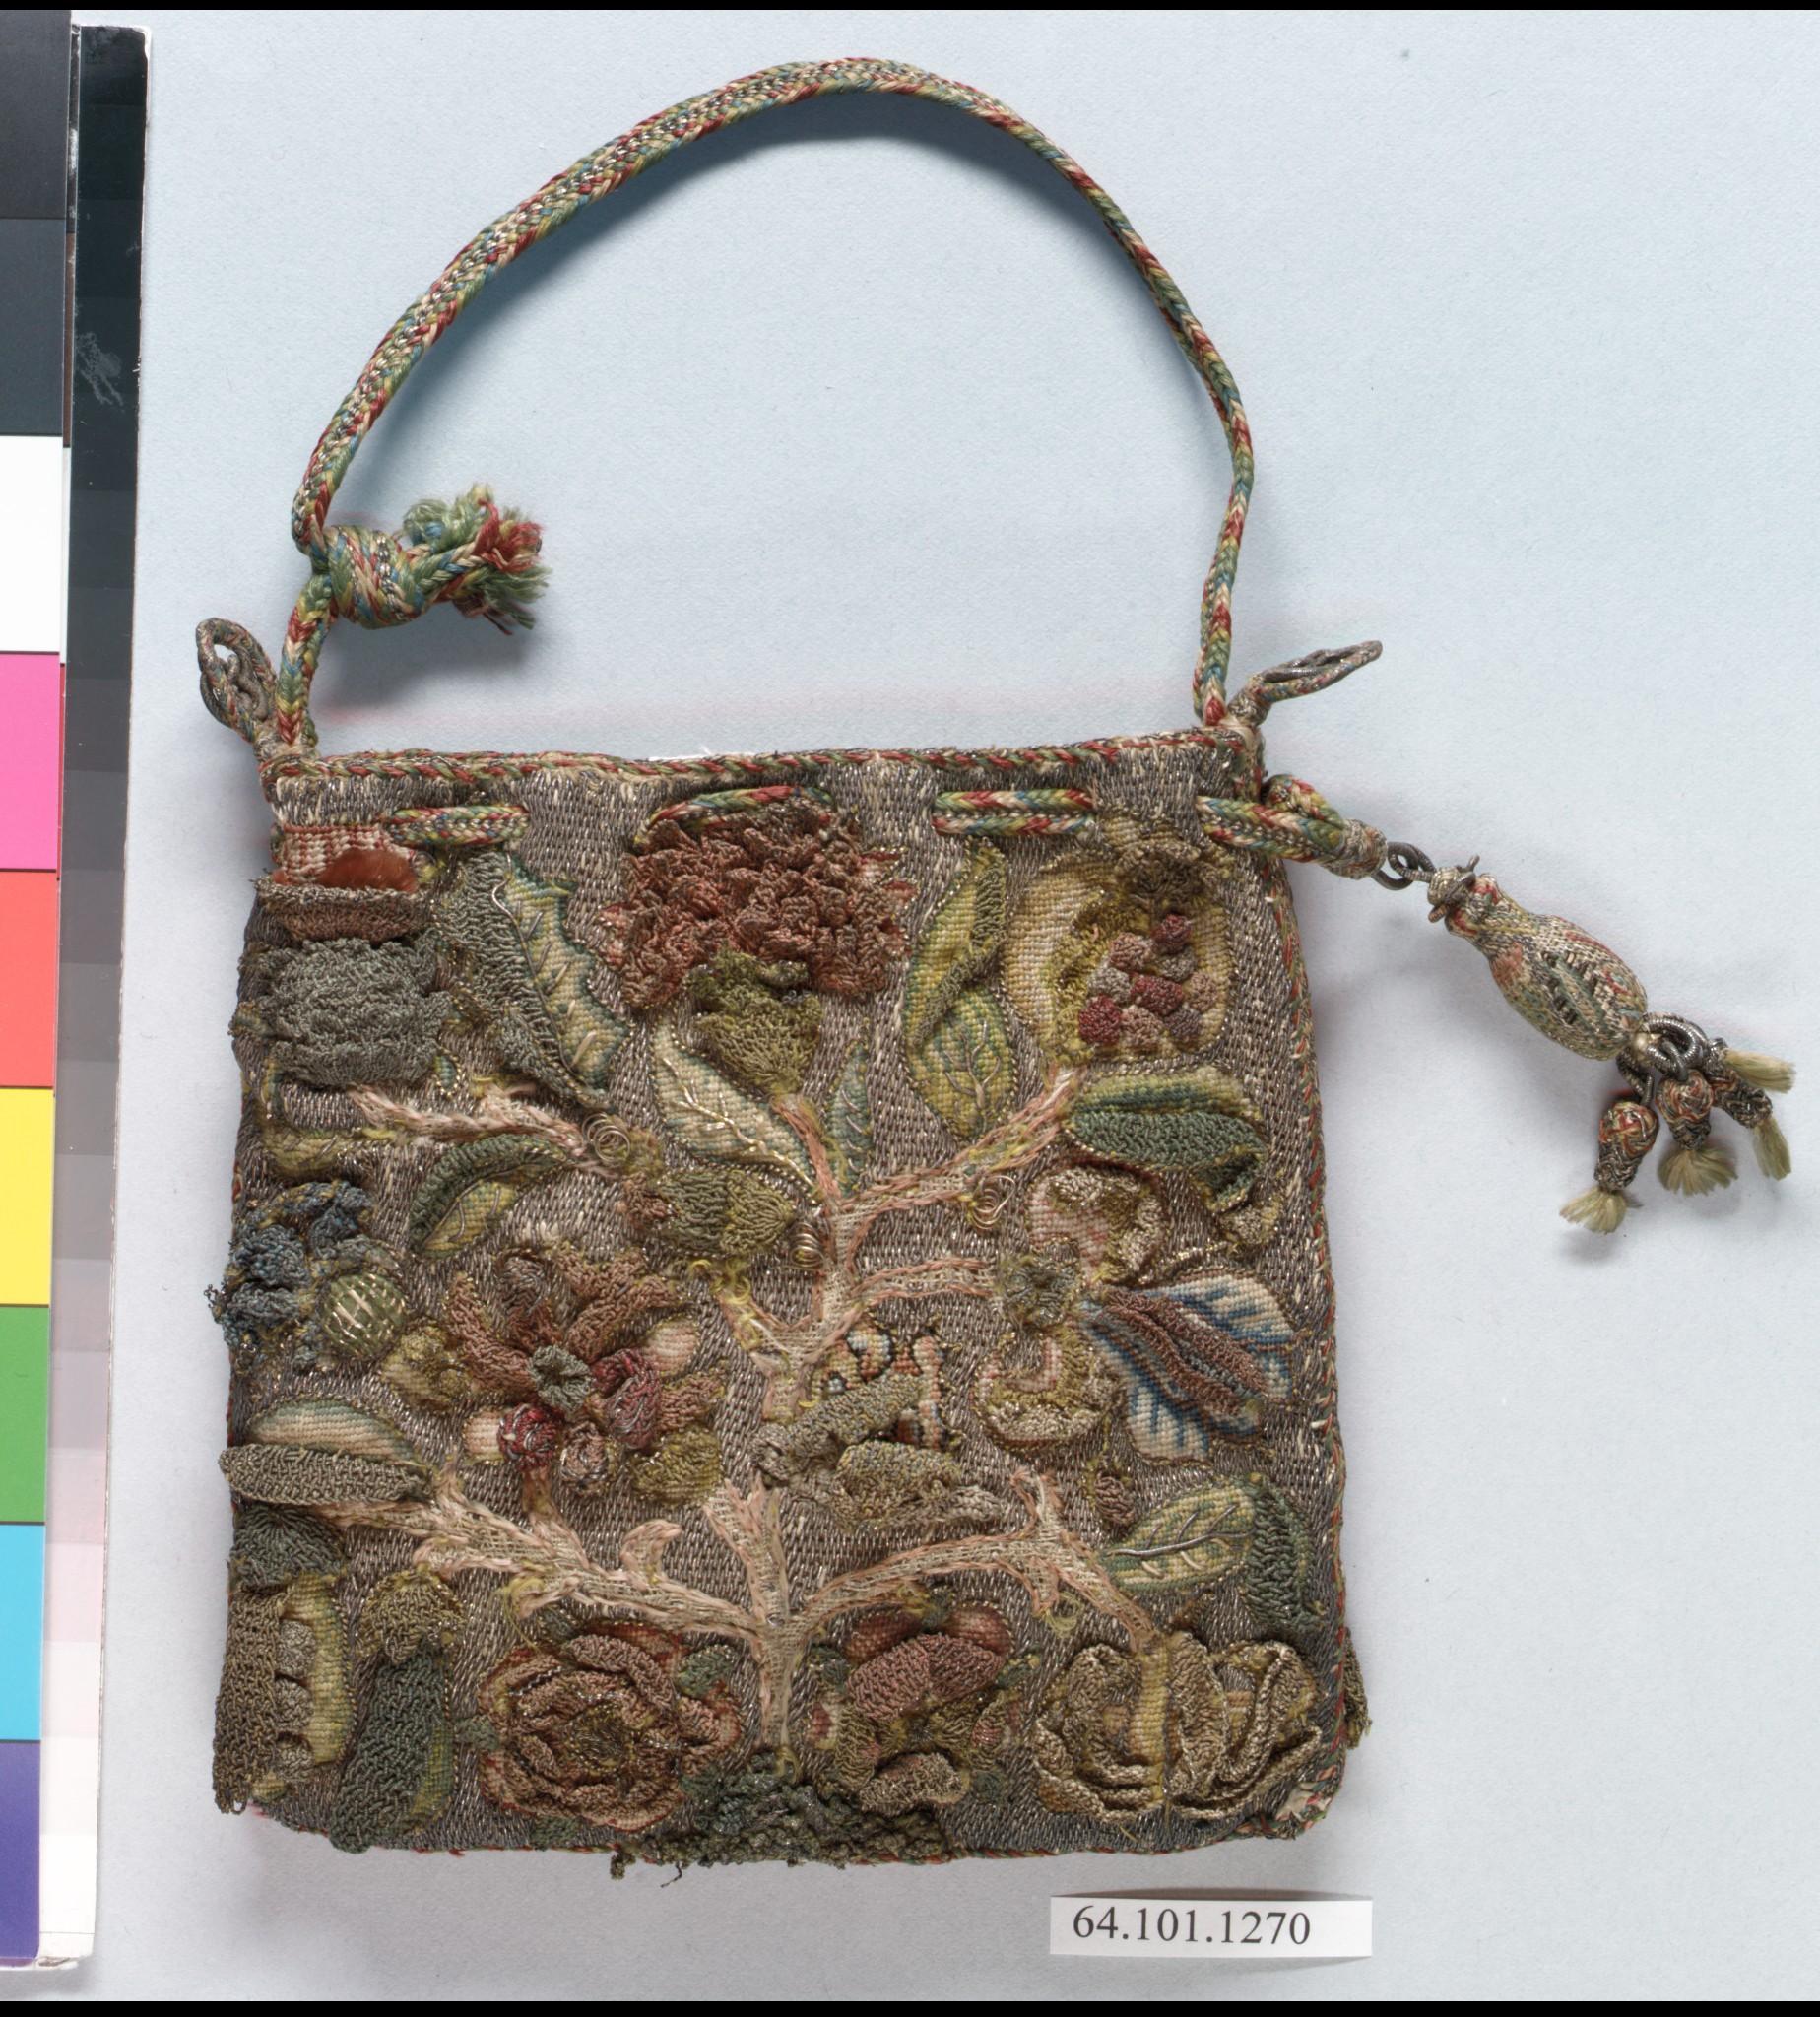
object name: purse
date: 1601-1625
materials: canvas, metal thread, silk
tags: flowers